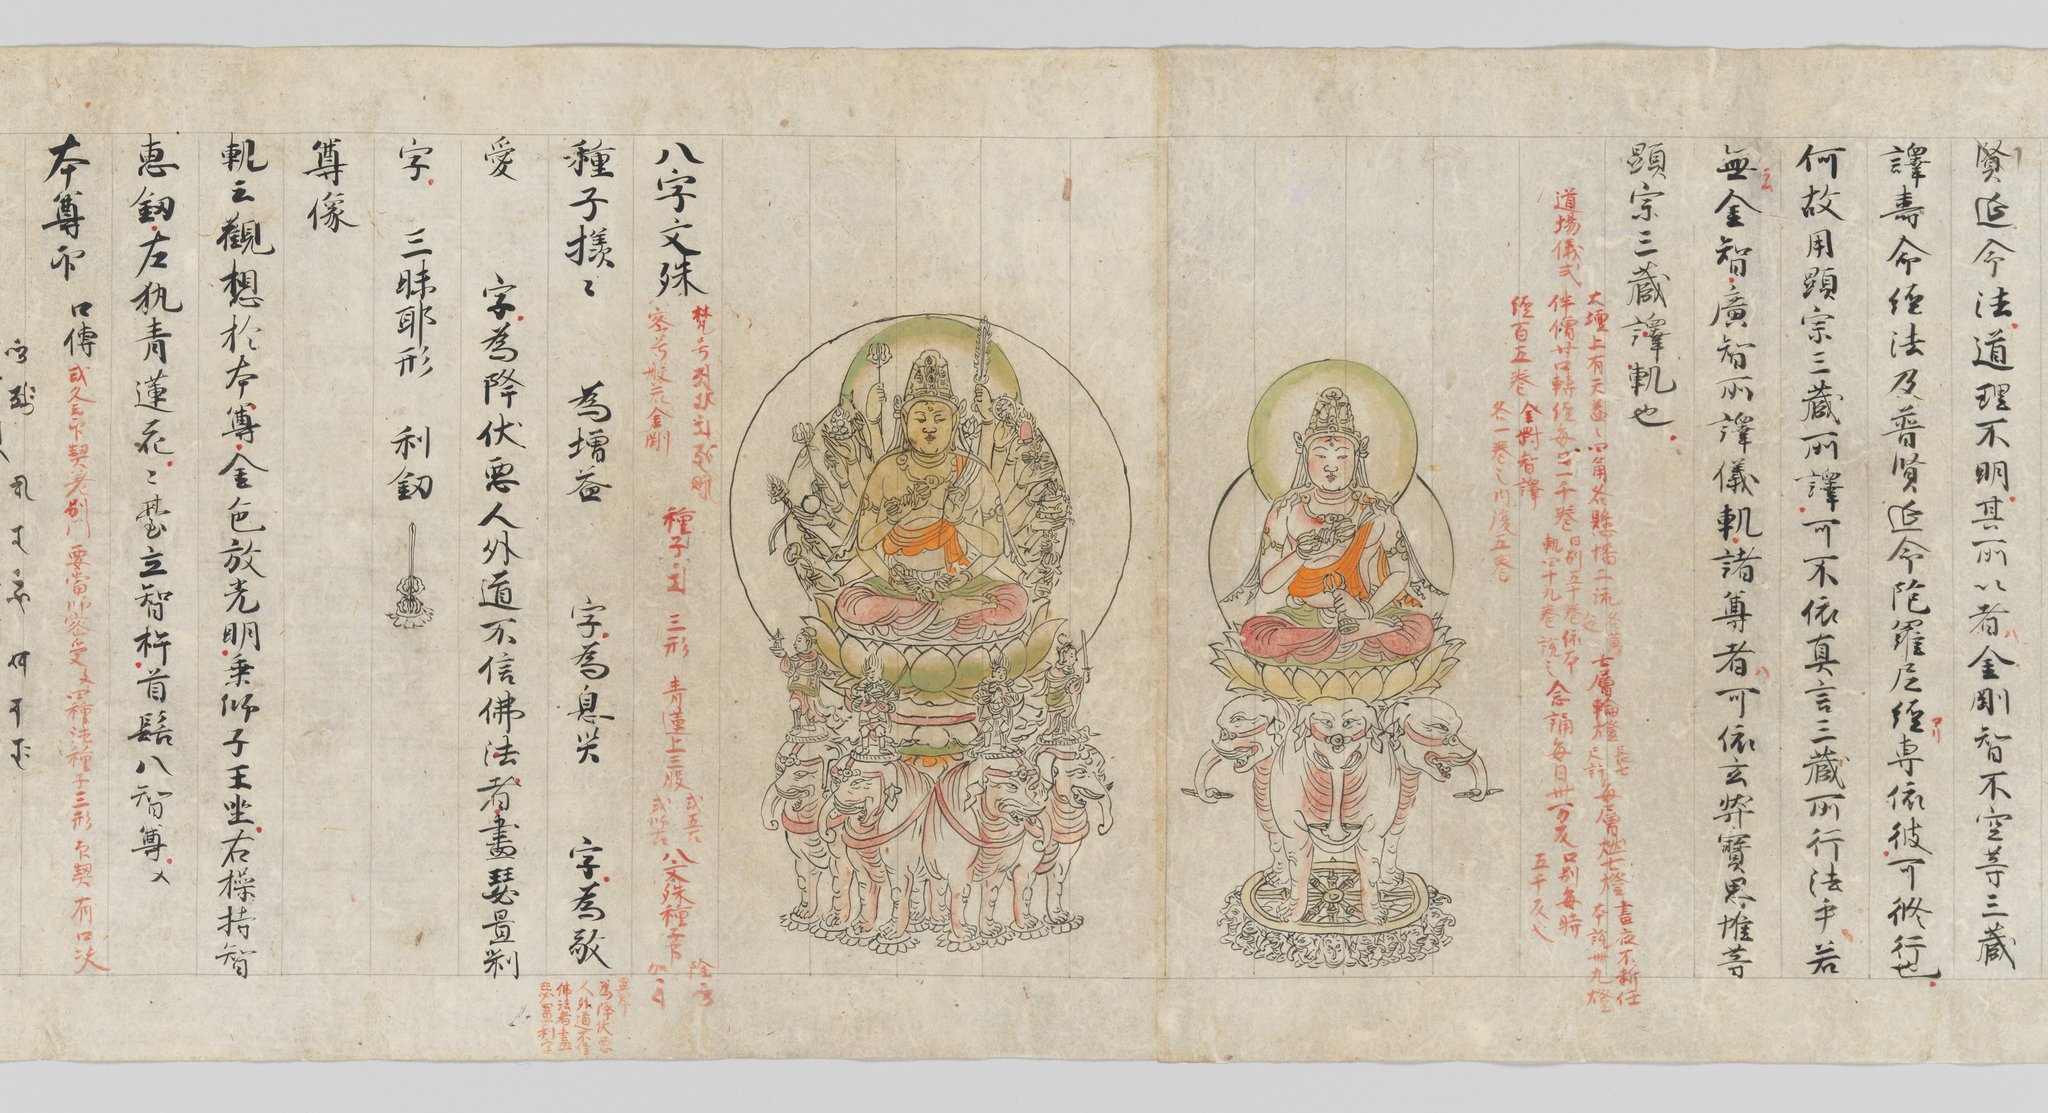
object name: handscroll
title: Scroll from the Compendium of Iconographic Drawings (Zuzōshō)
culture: japanese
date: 1167-1200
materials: ink, paper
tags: buddhism,deities